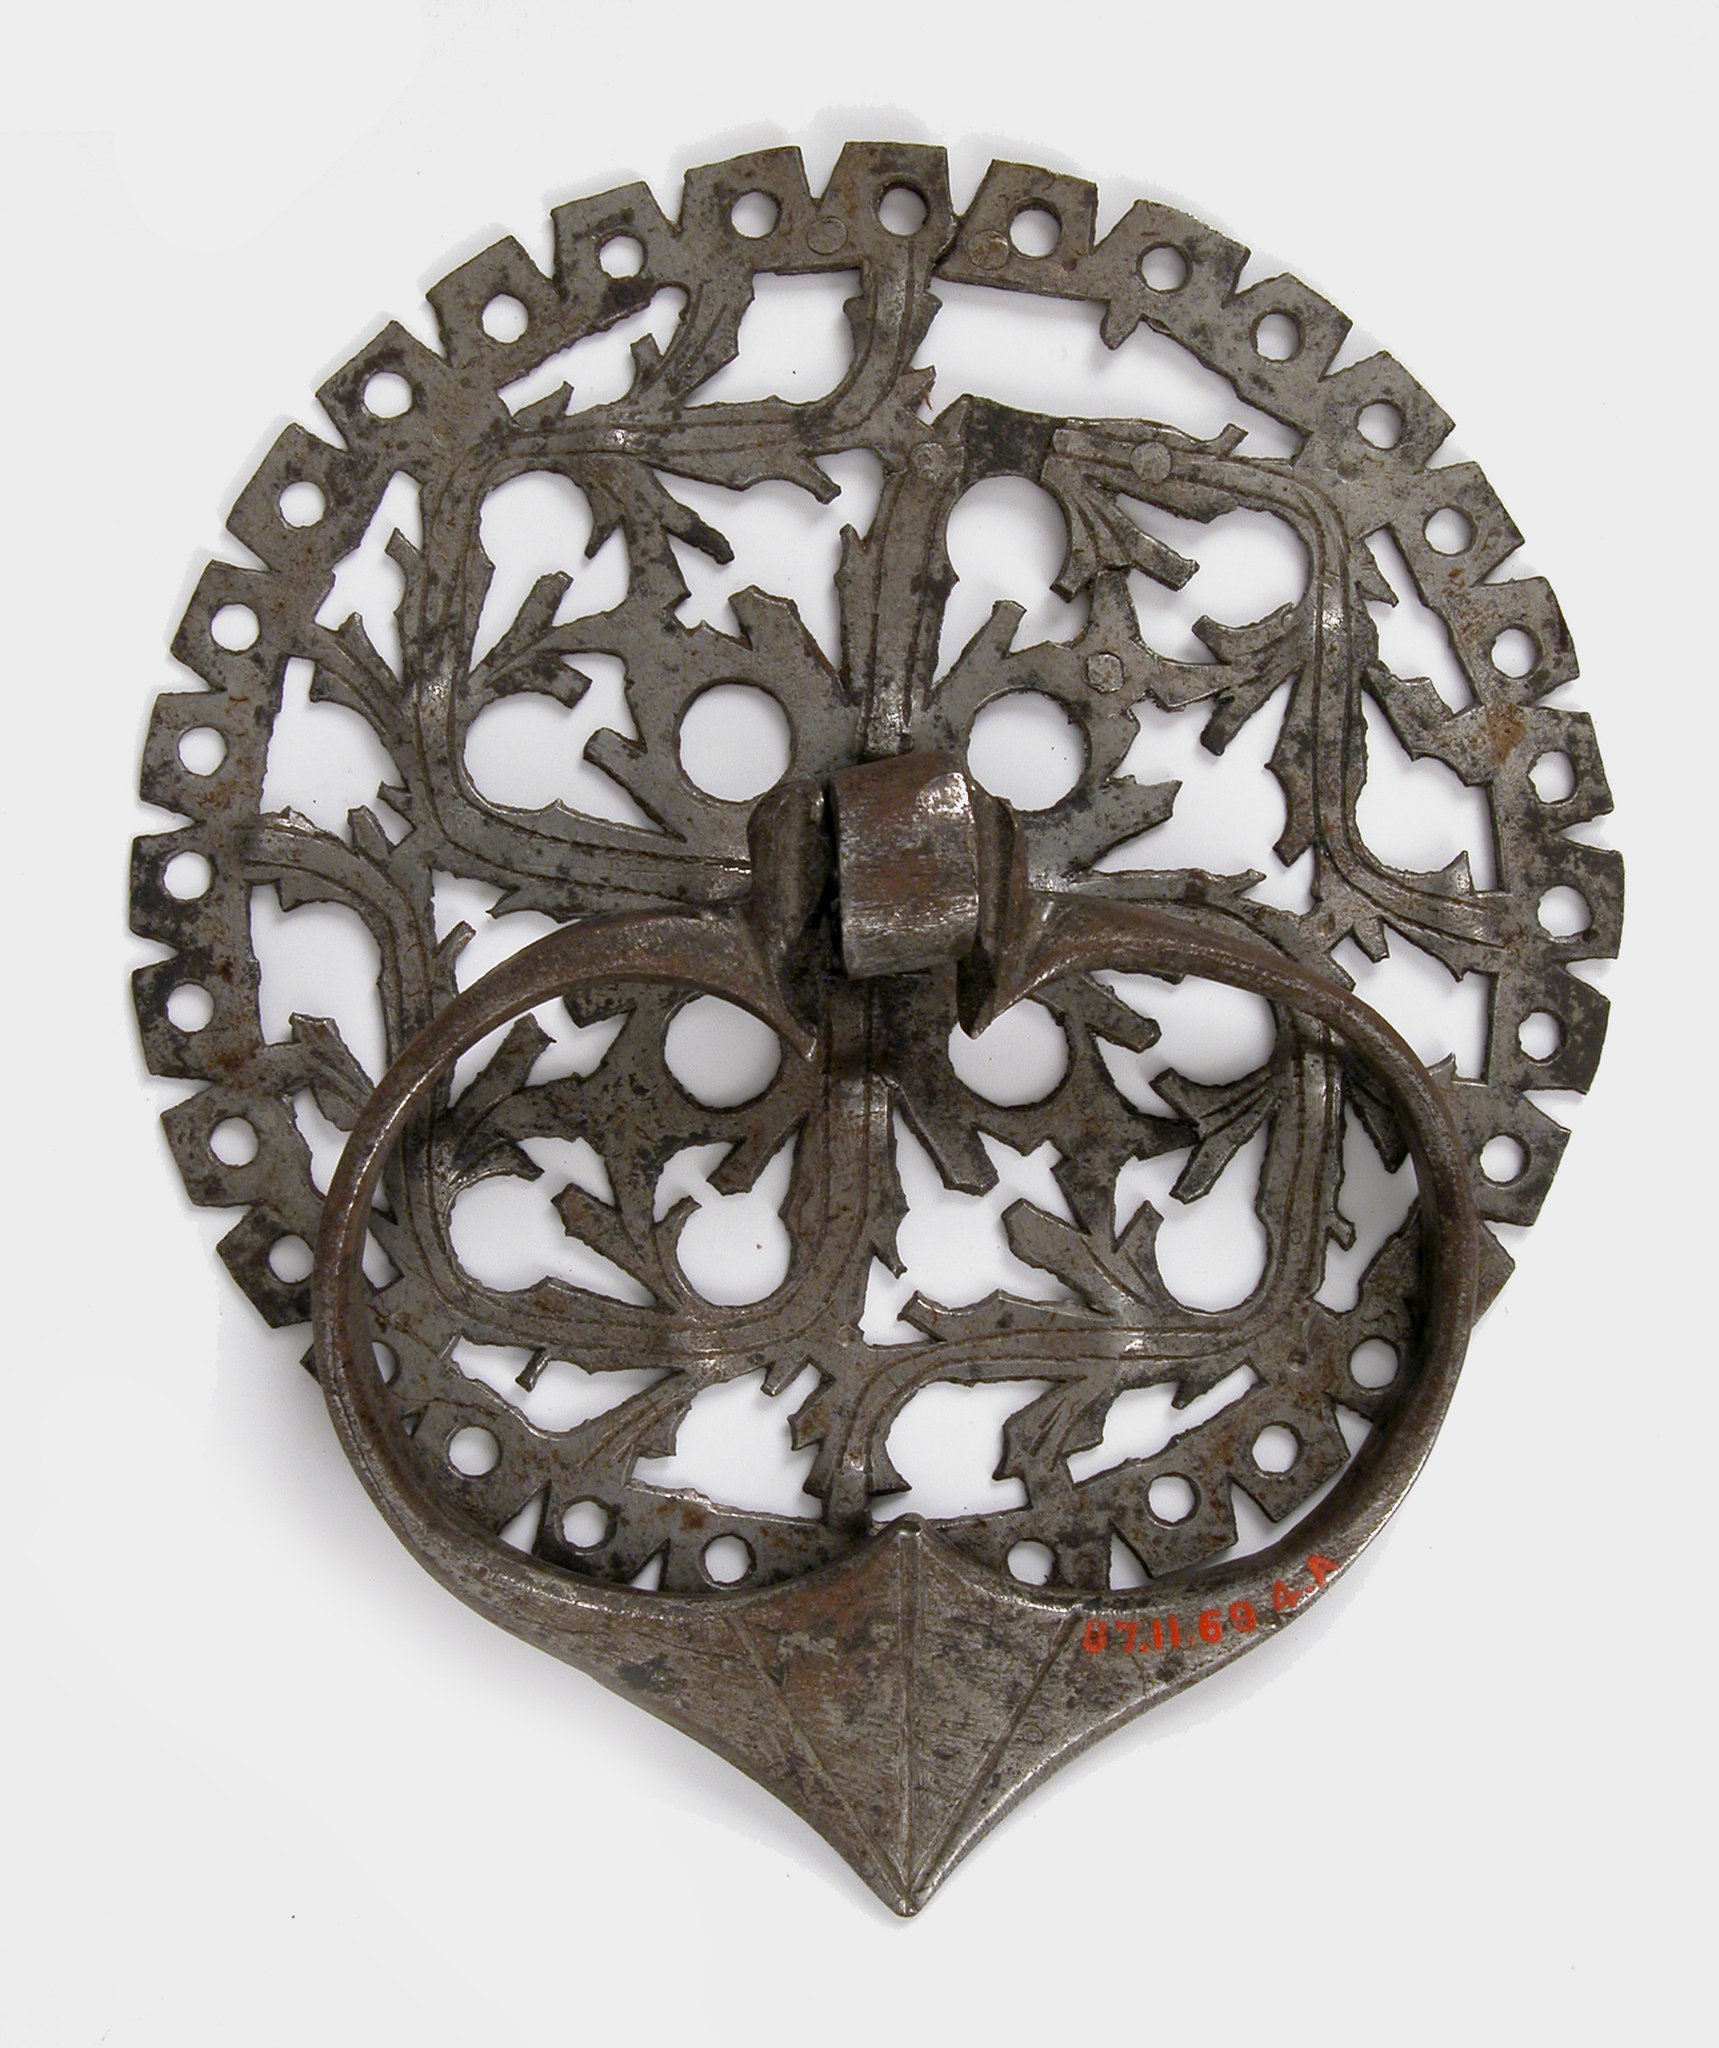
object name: door handle and plate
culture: german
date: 1401-1500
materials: iron